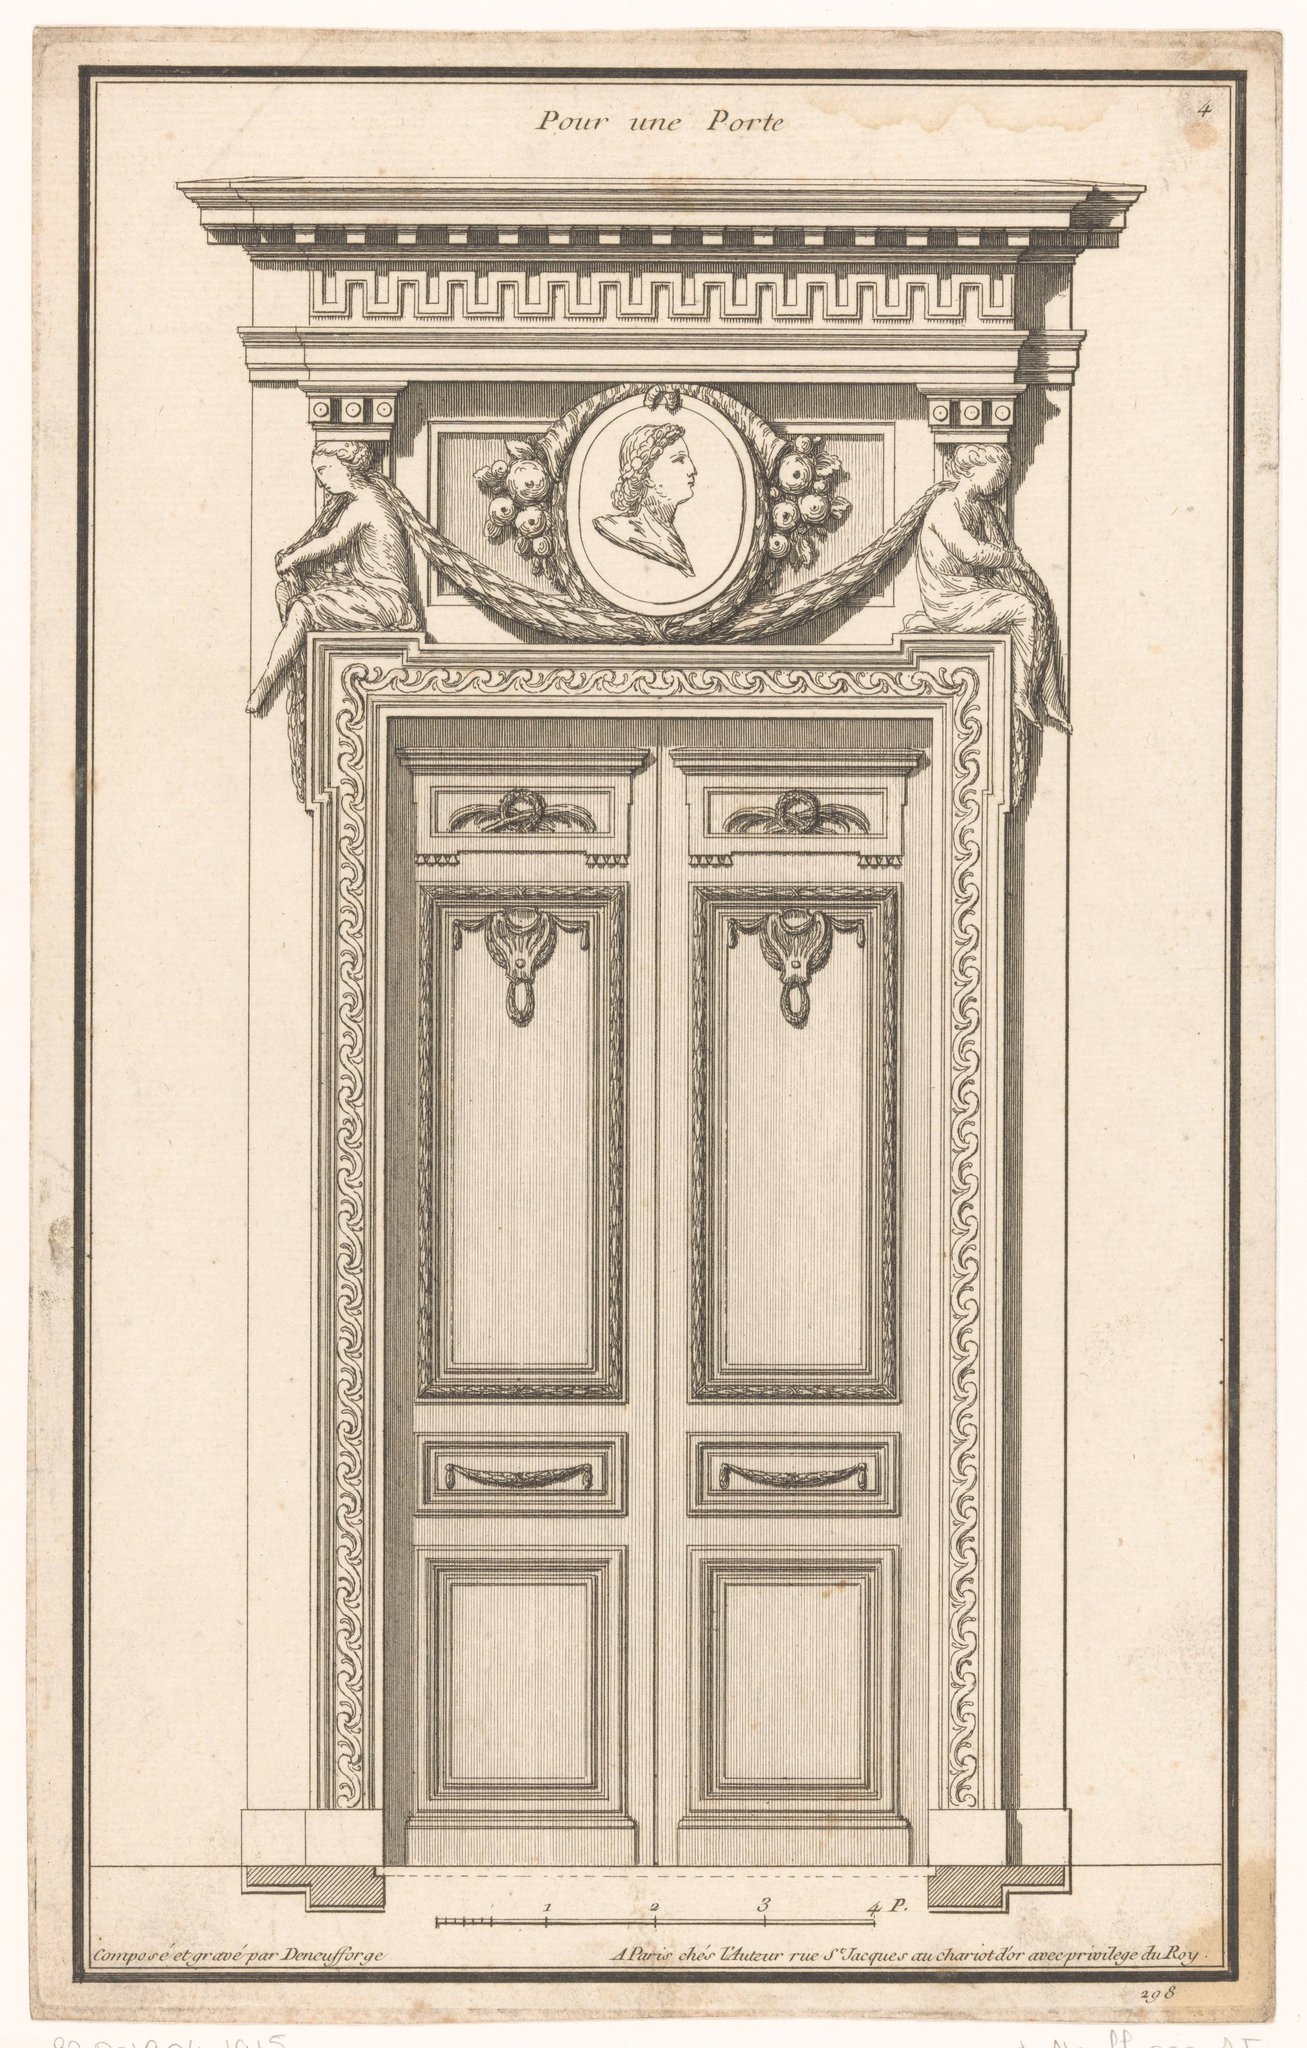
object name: ornament print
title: Deuren met medaillons en hoornen des overvloeds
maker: jean françois de neufforge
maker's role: print maker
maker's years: 1714-1791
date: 1763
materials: paper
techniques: etching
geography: paris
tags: 'cornucopia', horn of plenty, monumental door, porch, 'aediculum', ornament ~ medallion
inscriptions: collector's mark: Lugt 2228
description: Een geornamenteerde deur met rocailles en guirlandes. Daarboven een medaillon met vrouwenportret en profil, hoornen des overvloeds en twee zittende figuren met guirlandes. Prentnummer 298.